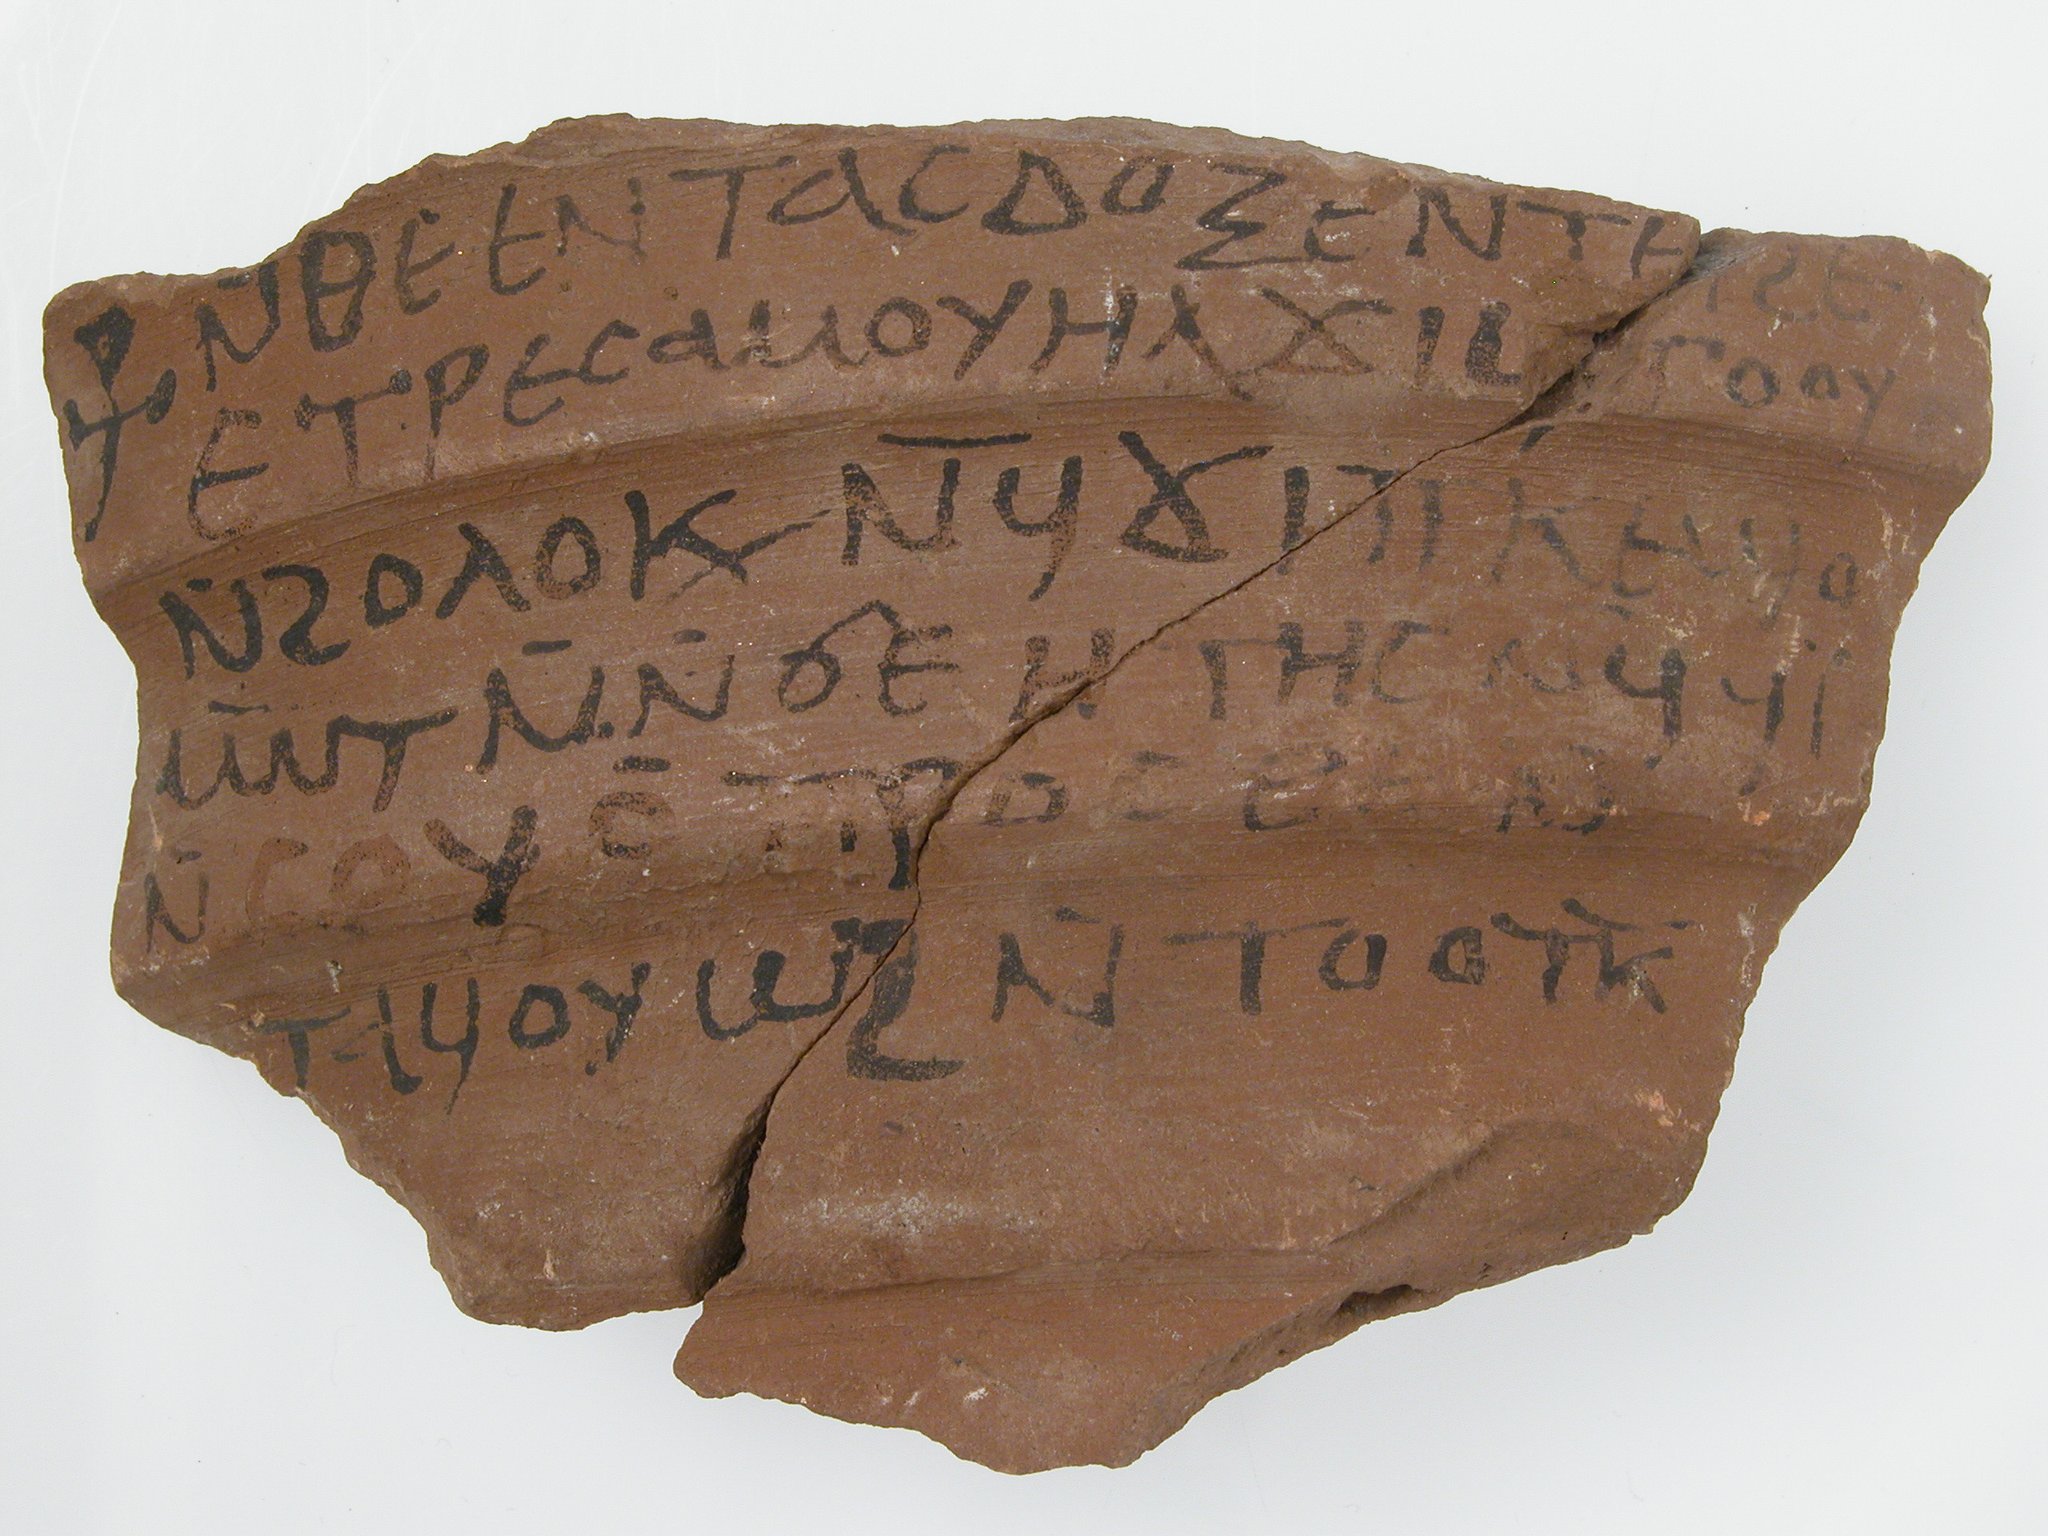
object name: ostrakon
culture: coptic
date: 601-700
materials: ink, pottery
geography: egypt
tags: coptic